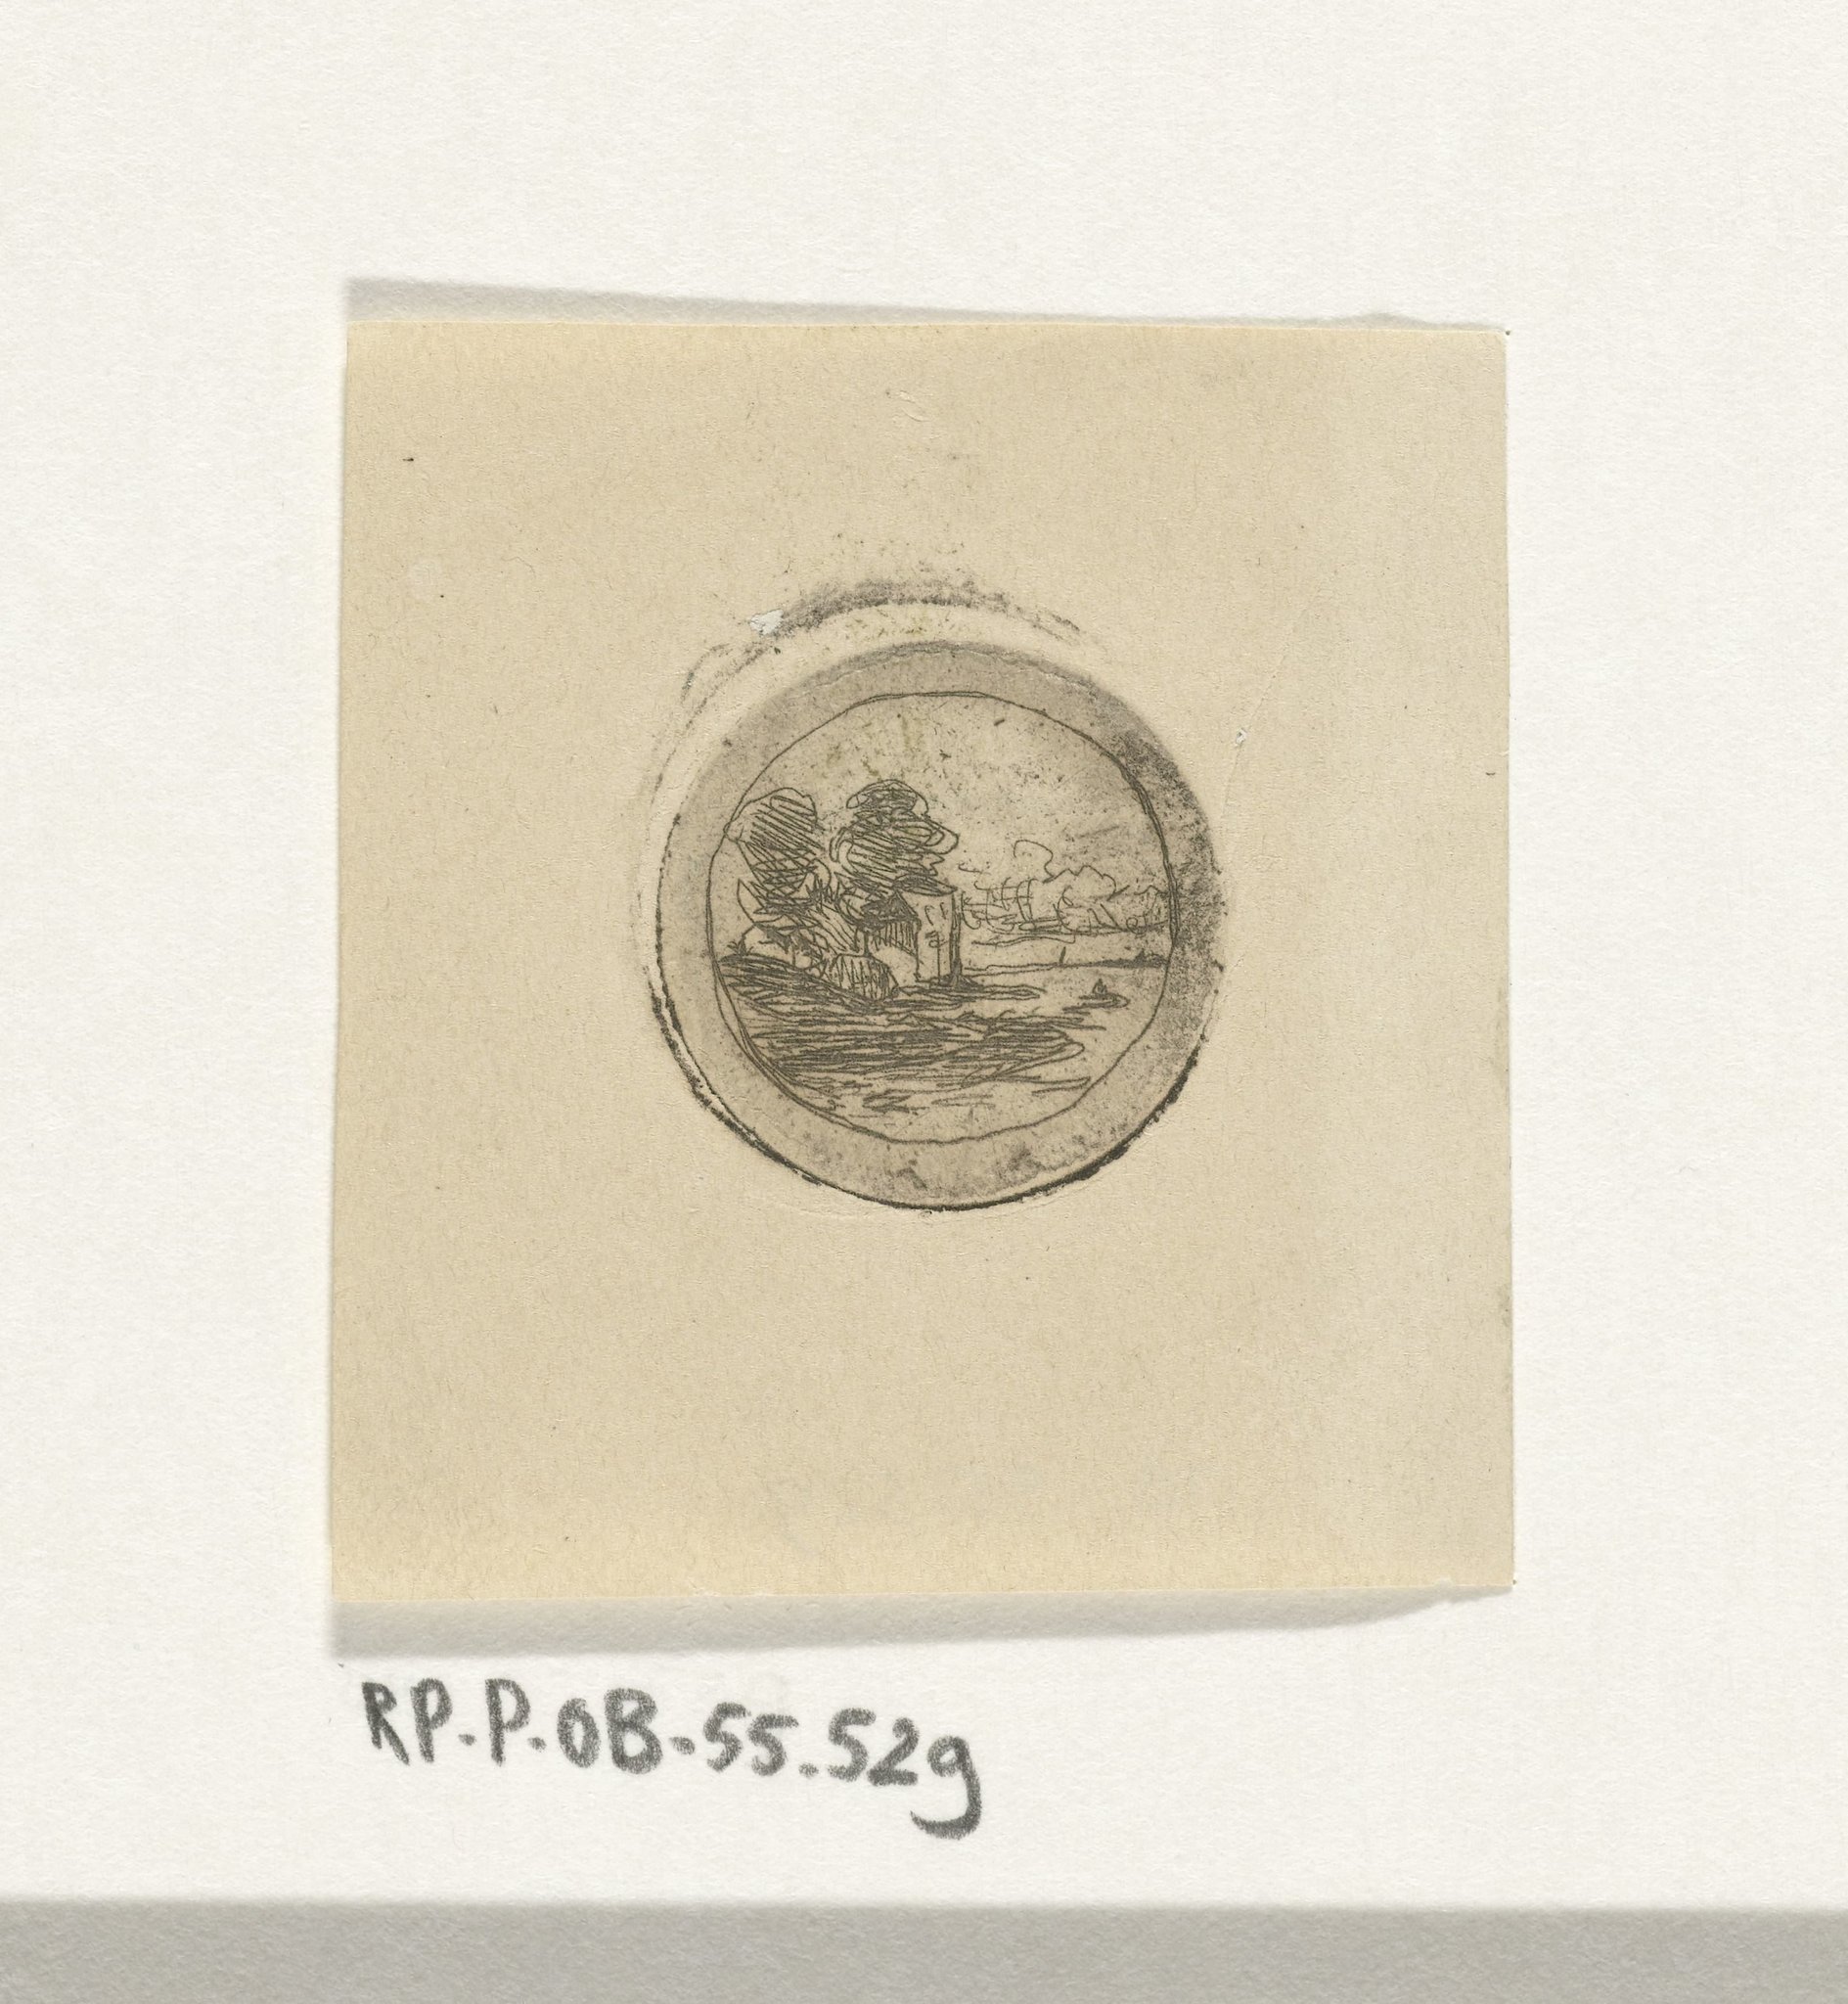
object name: print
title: Rivierlandschap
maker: lambertus hardenberg (1822-1900)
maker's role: draughtsman, painter, print maker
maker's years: 1822-1900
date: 1837-1900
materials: paper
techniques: etching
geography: the hague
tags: landscapes with waters, waterscapes, seascapes (in the temperate zone)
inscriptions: collector's mark: Lugt 2228